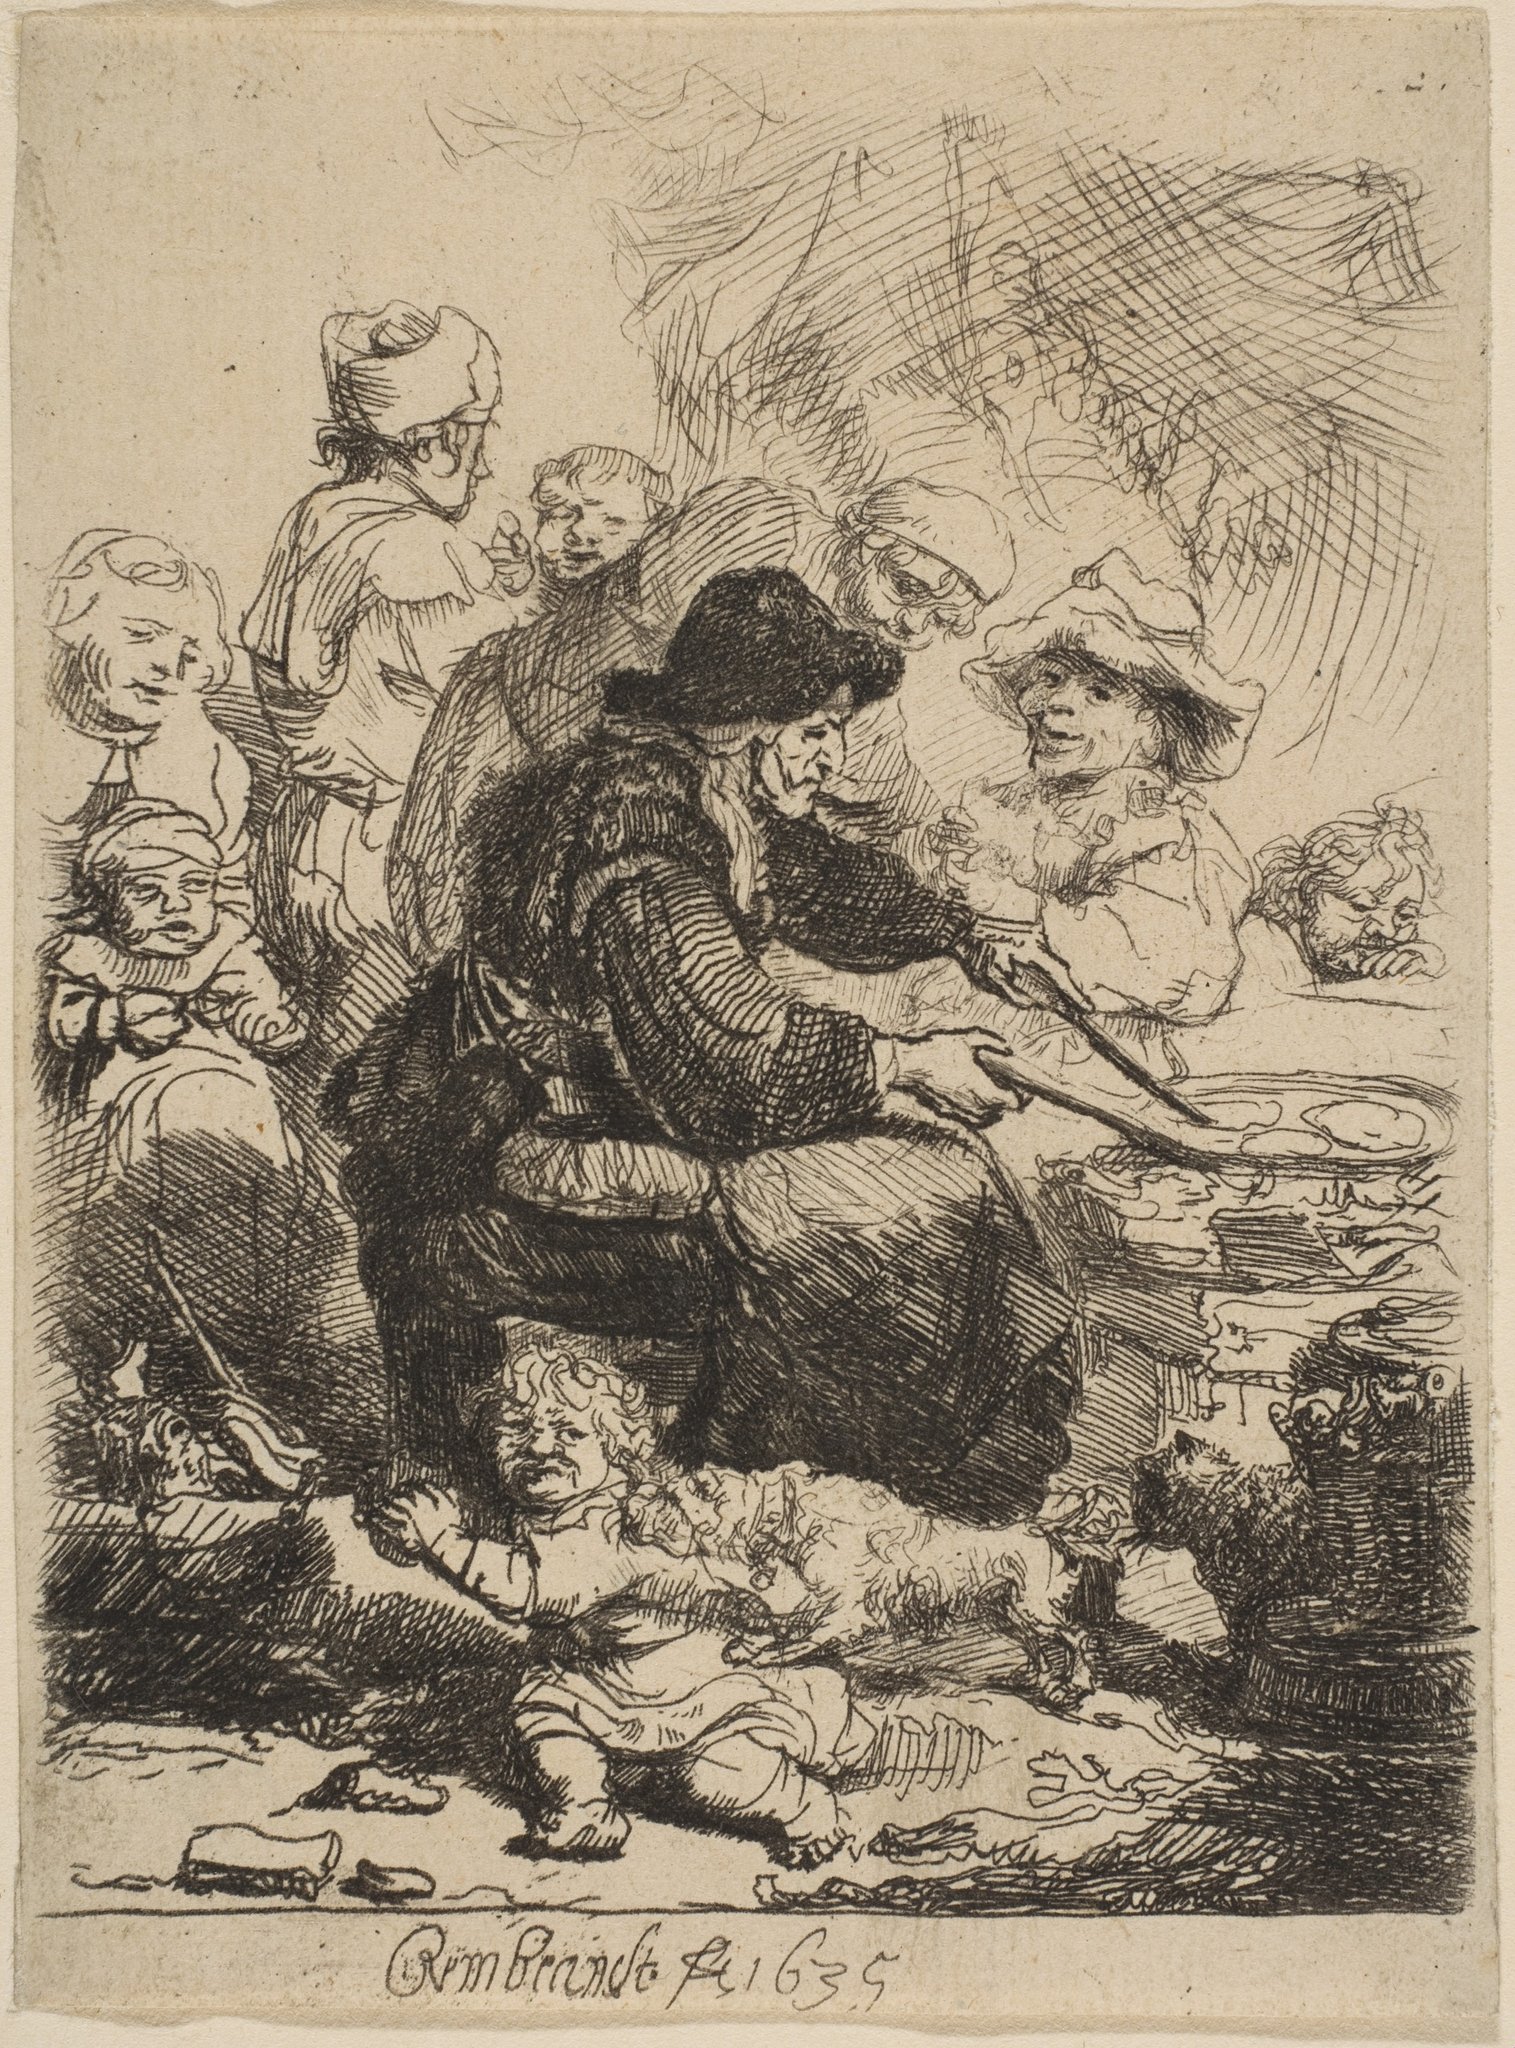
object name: print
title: The Pancake Woman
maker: rembrandt van rijn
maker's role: artist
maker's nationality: dutch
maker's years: 1606-1669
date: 1635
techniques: etching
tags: boys,men,women,working